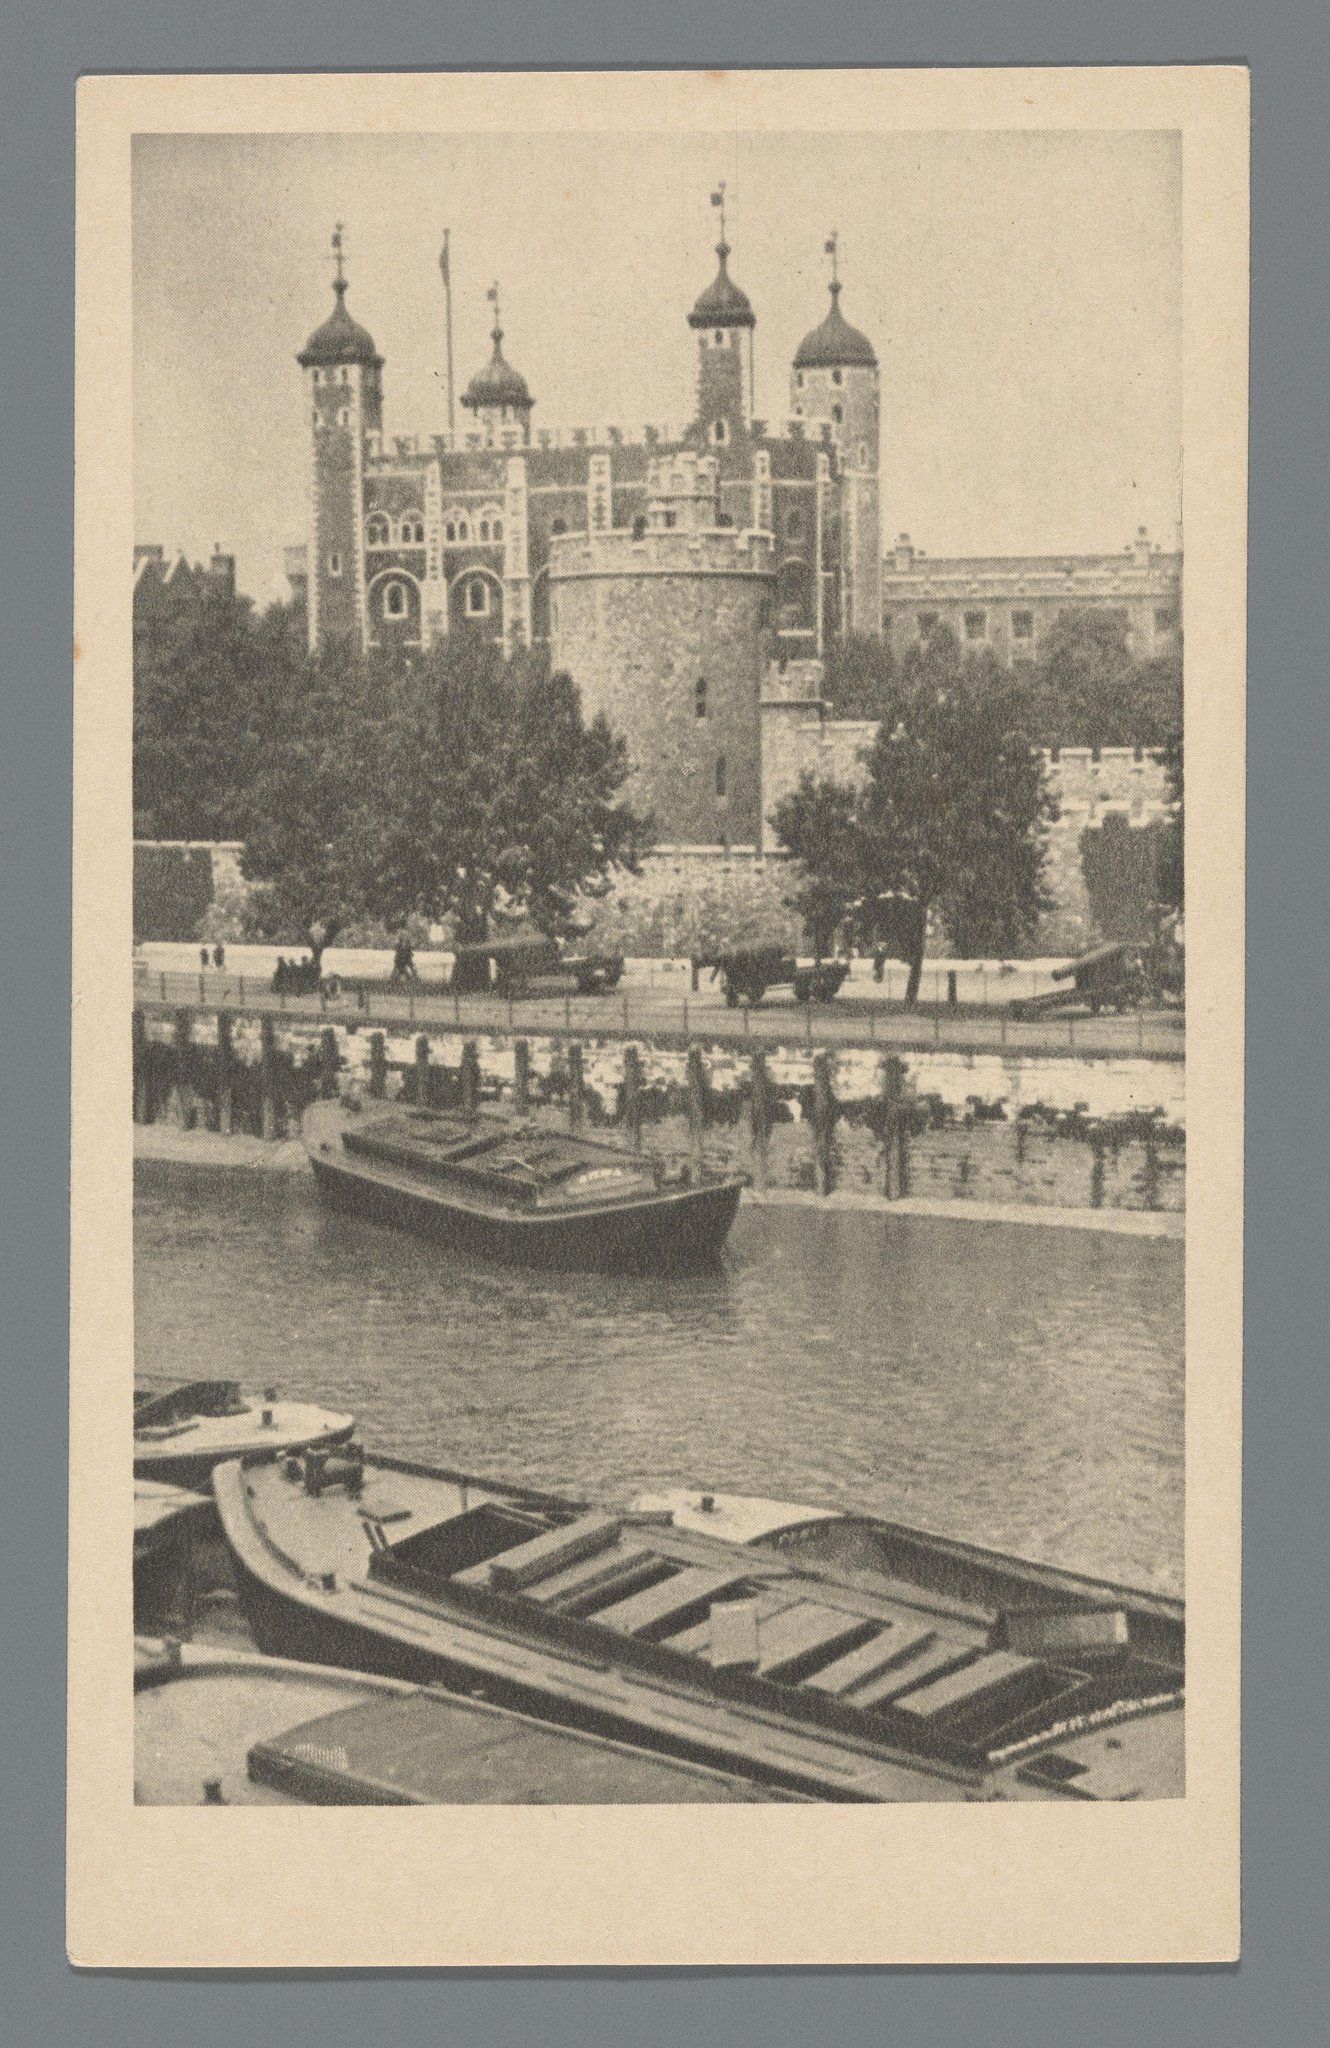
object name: ansichtkaart, prentbriefkaart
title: Gezicht op de Tower of London aan de Theems met boten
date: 1914-2024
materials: cardboard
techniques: photoaquatint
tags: castle, river, tow-boat, towing-barge